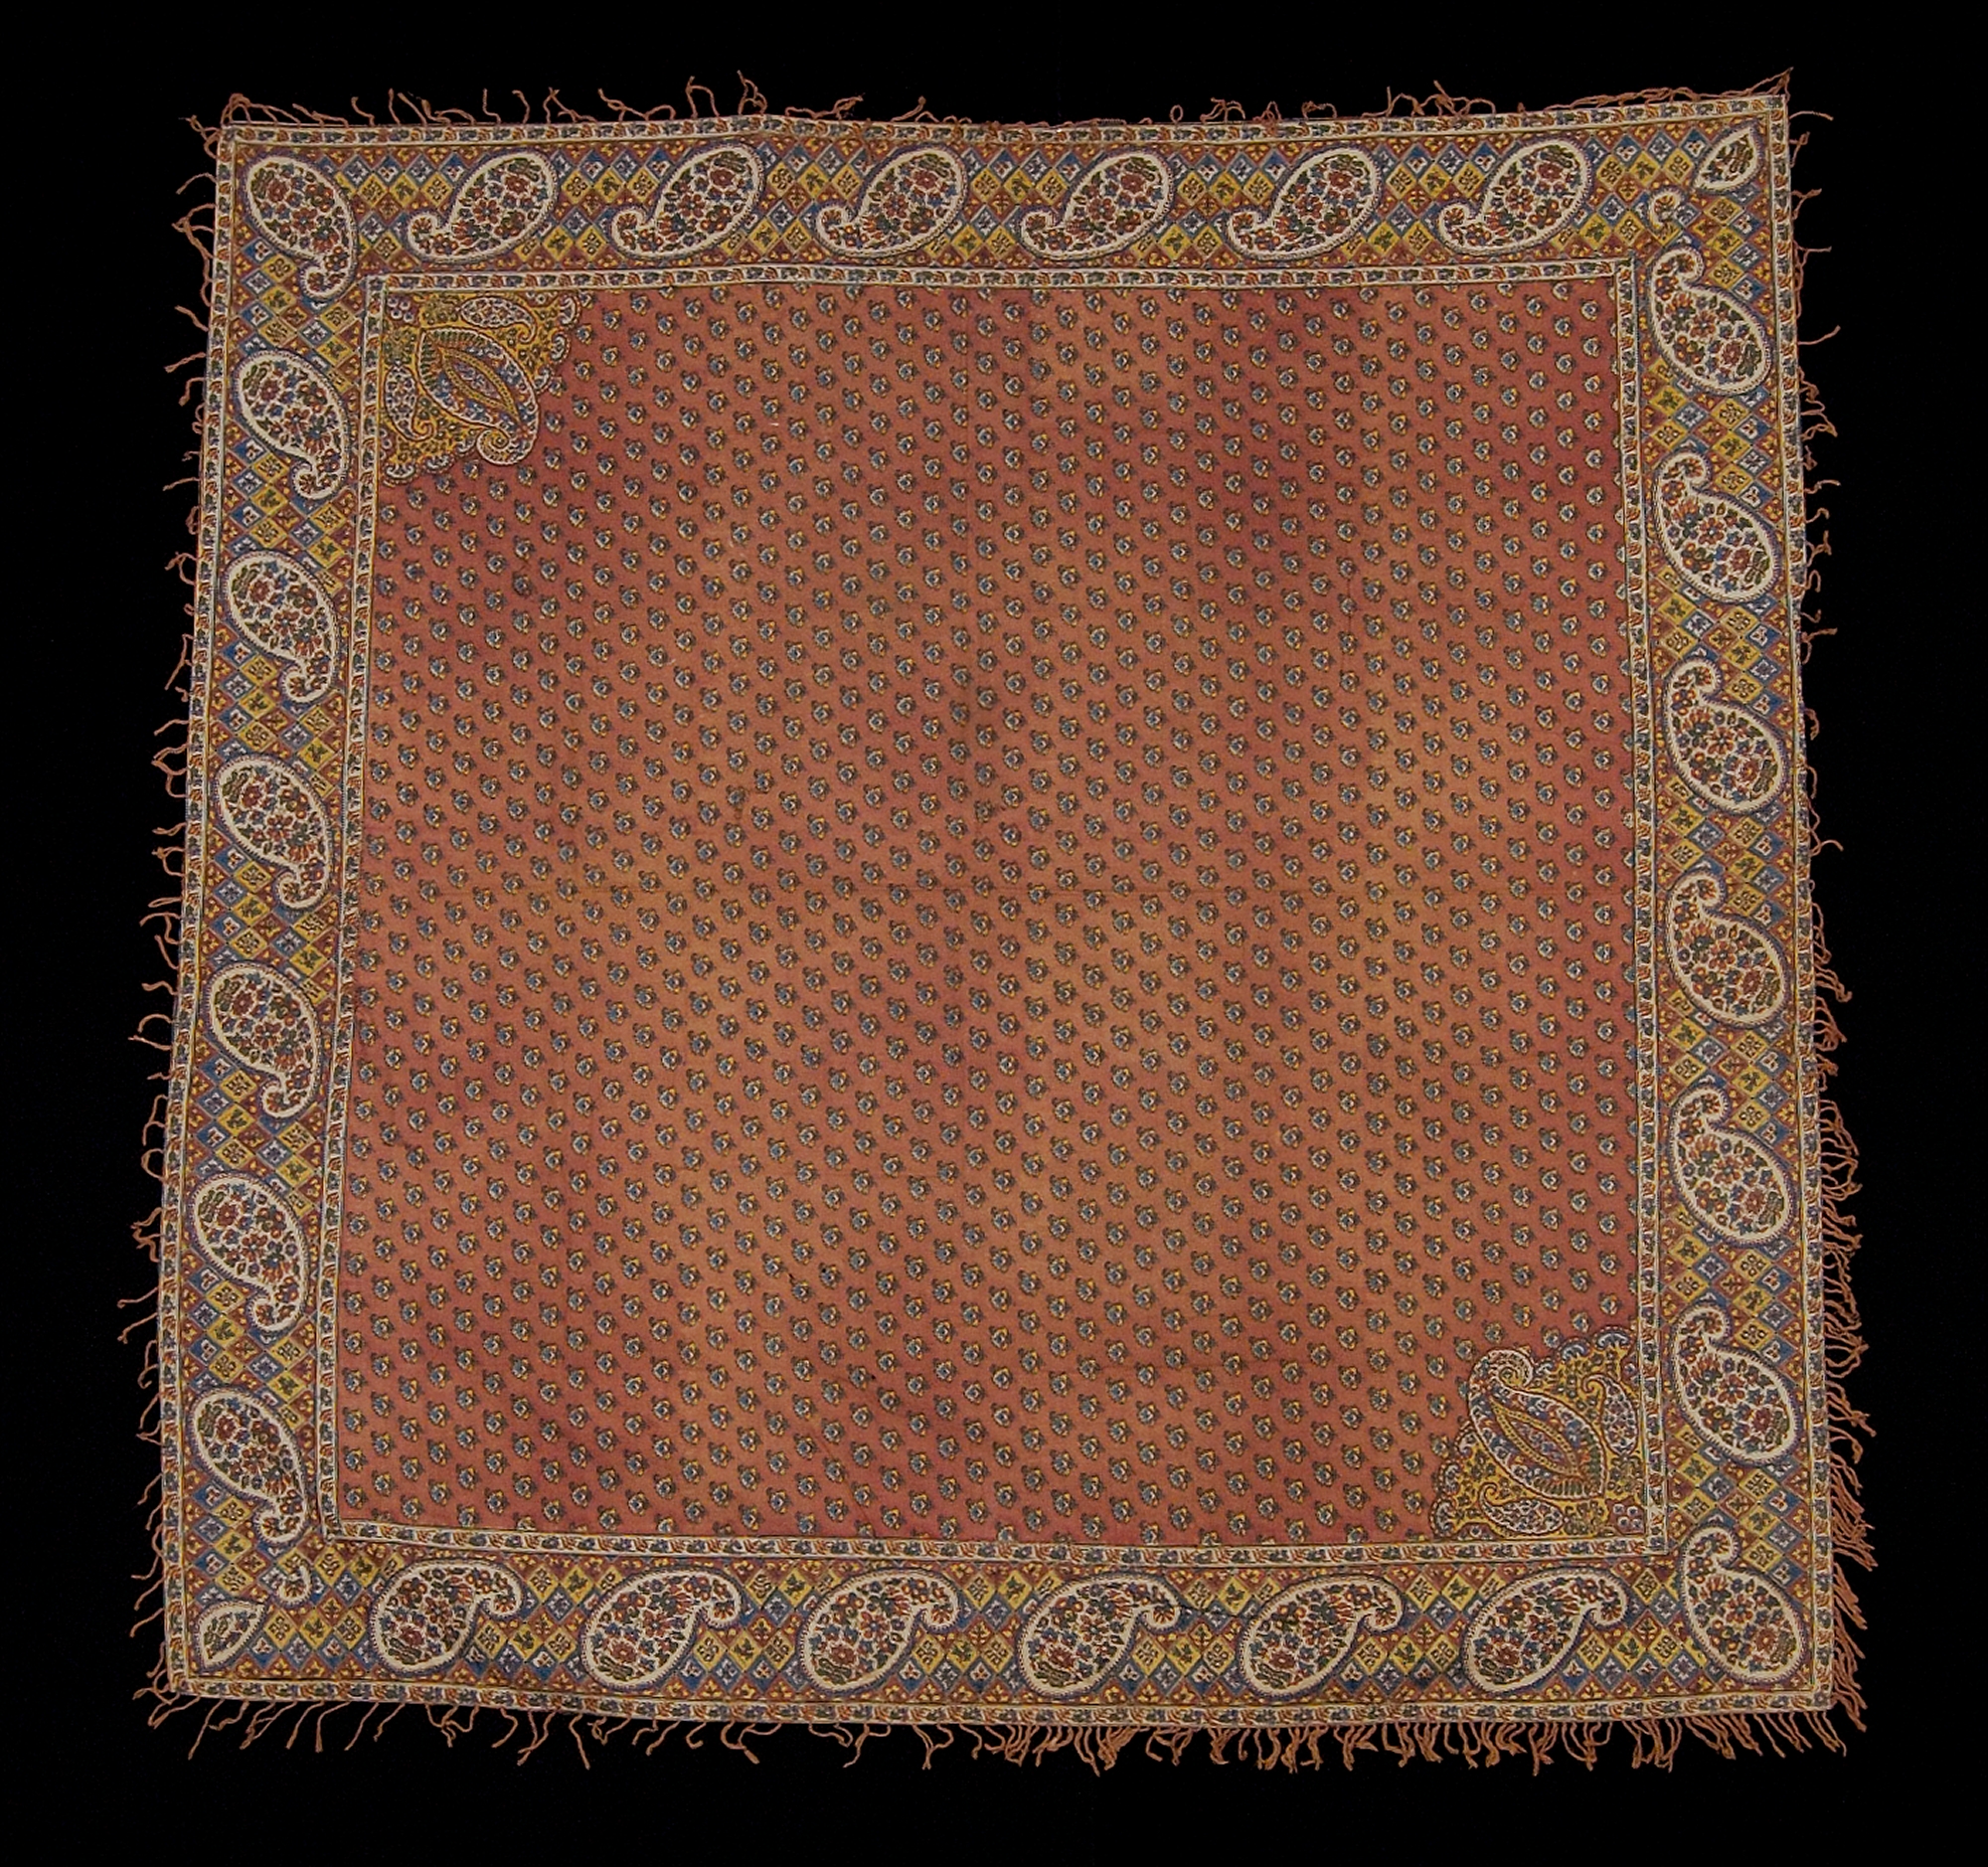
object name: shawl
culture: american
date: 1805-1815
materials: cotton